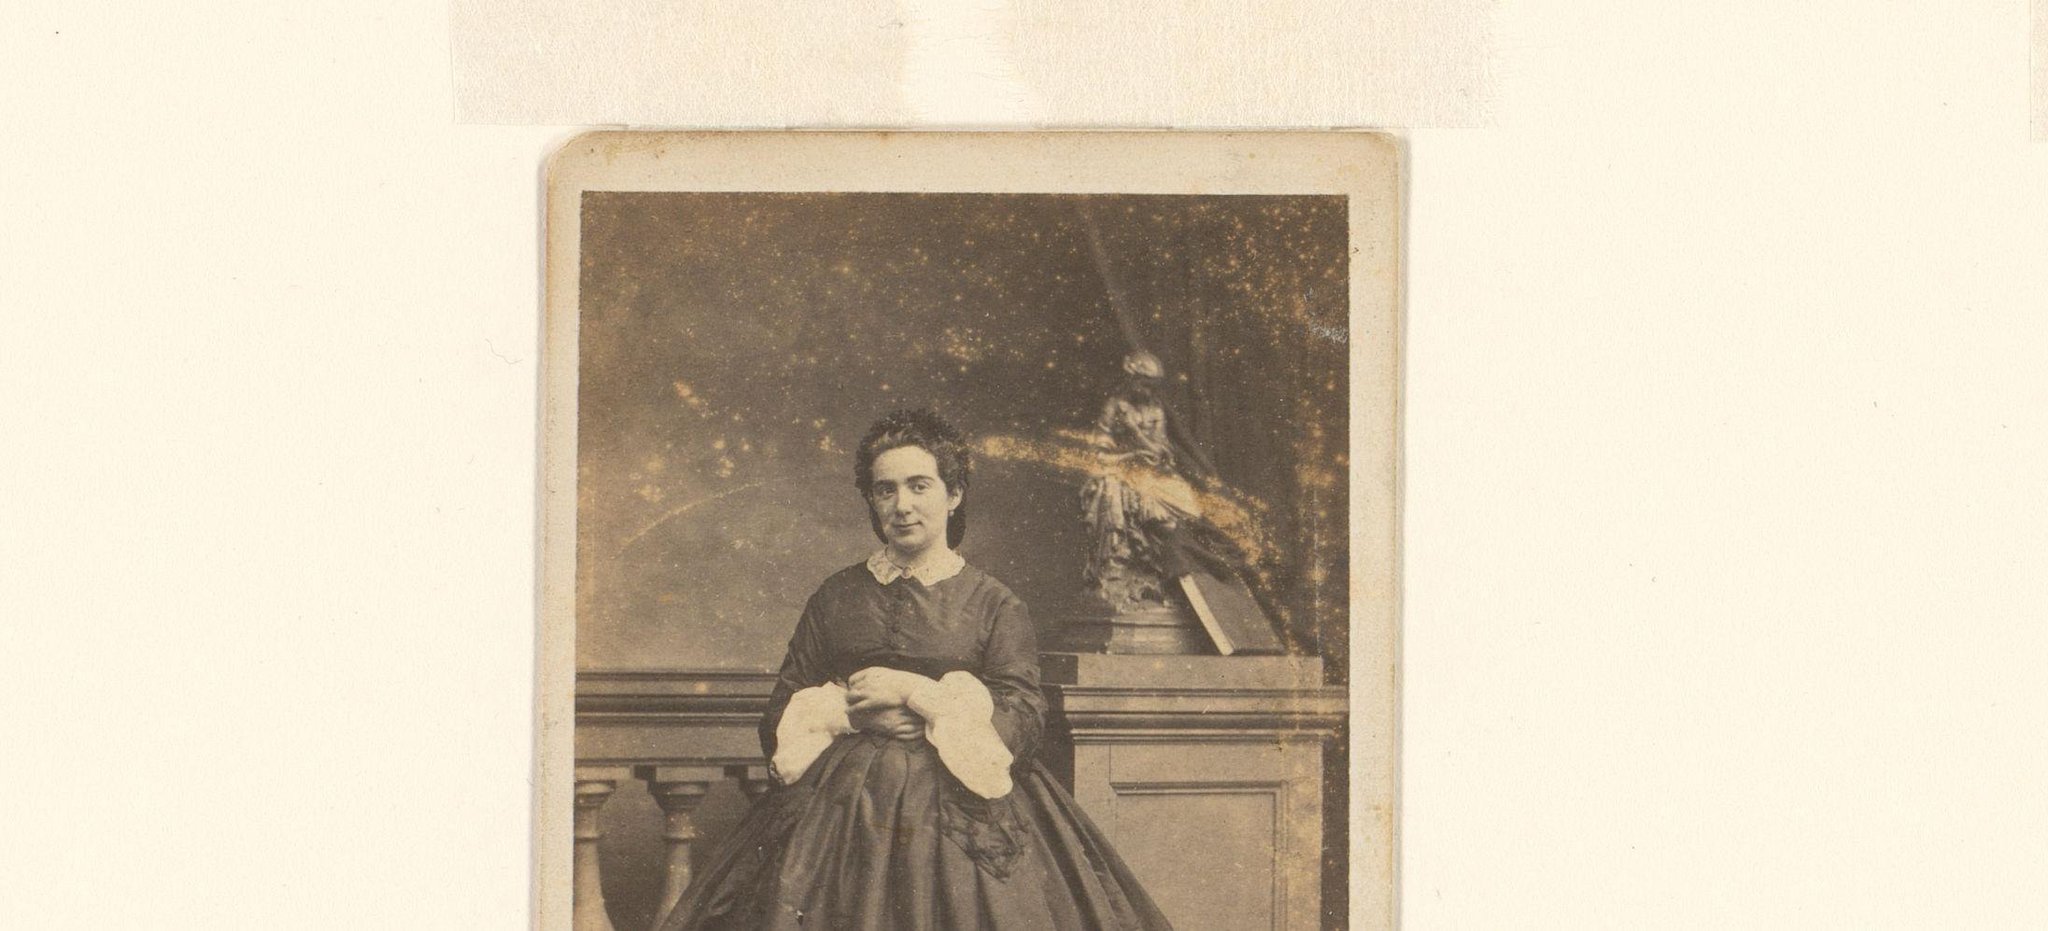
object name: carte de visite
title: Portret van een onbekend vrouwelijk lid van de familie Asser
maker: louis wegner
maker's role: print maker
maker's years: 1816-1864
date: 1857-1864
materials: cardboard, paper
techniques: albumen print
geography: amsterdam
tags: adult woman, anonymous historical person portrayed, amsterdam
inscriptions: address: ‘Prinsengracht BB 439/ AMSTERDAM’